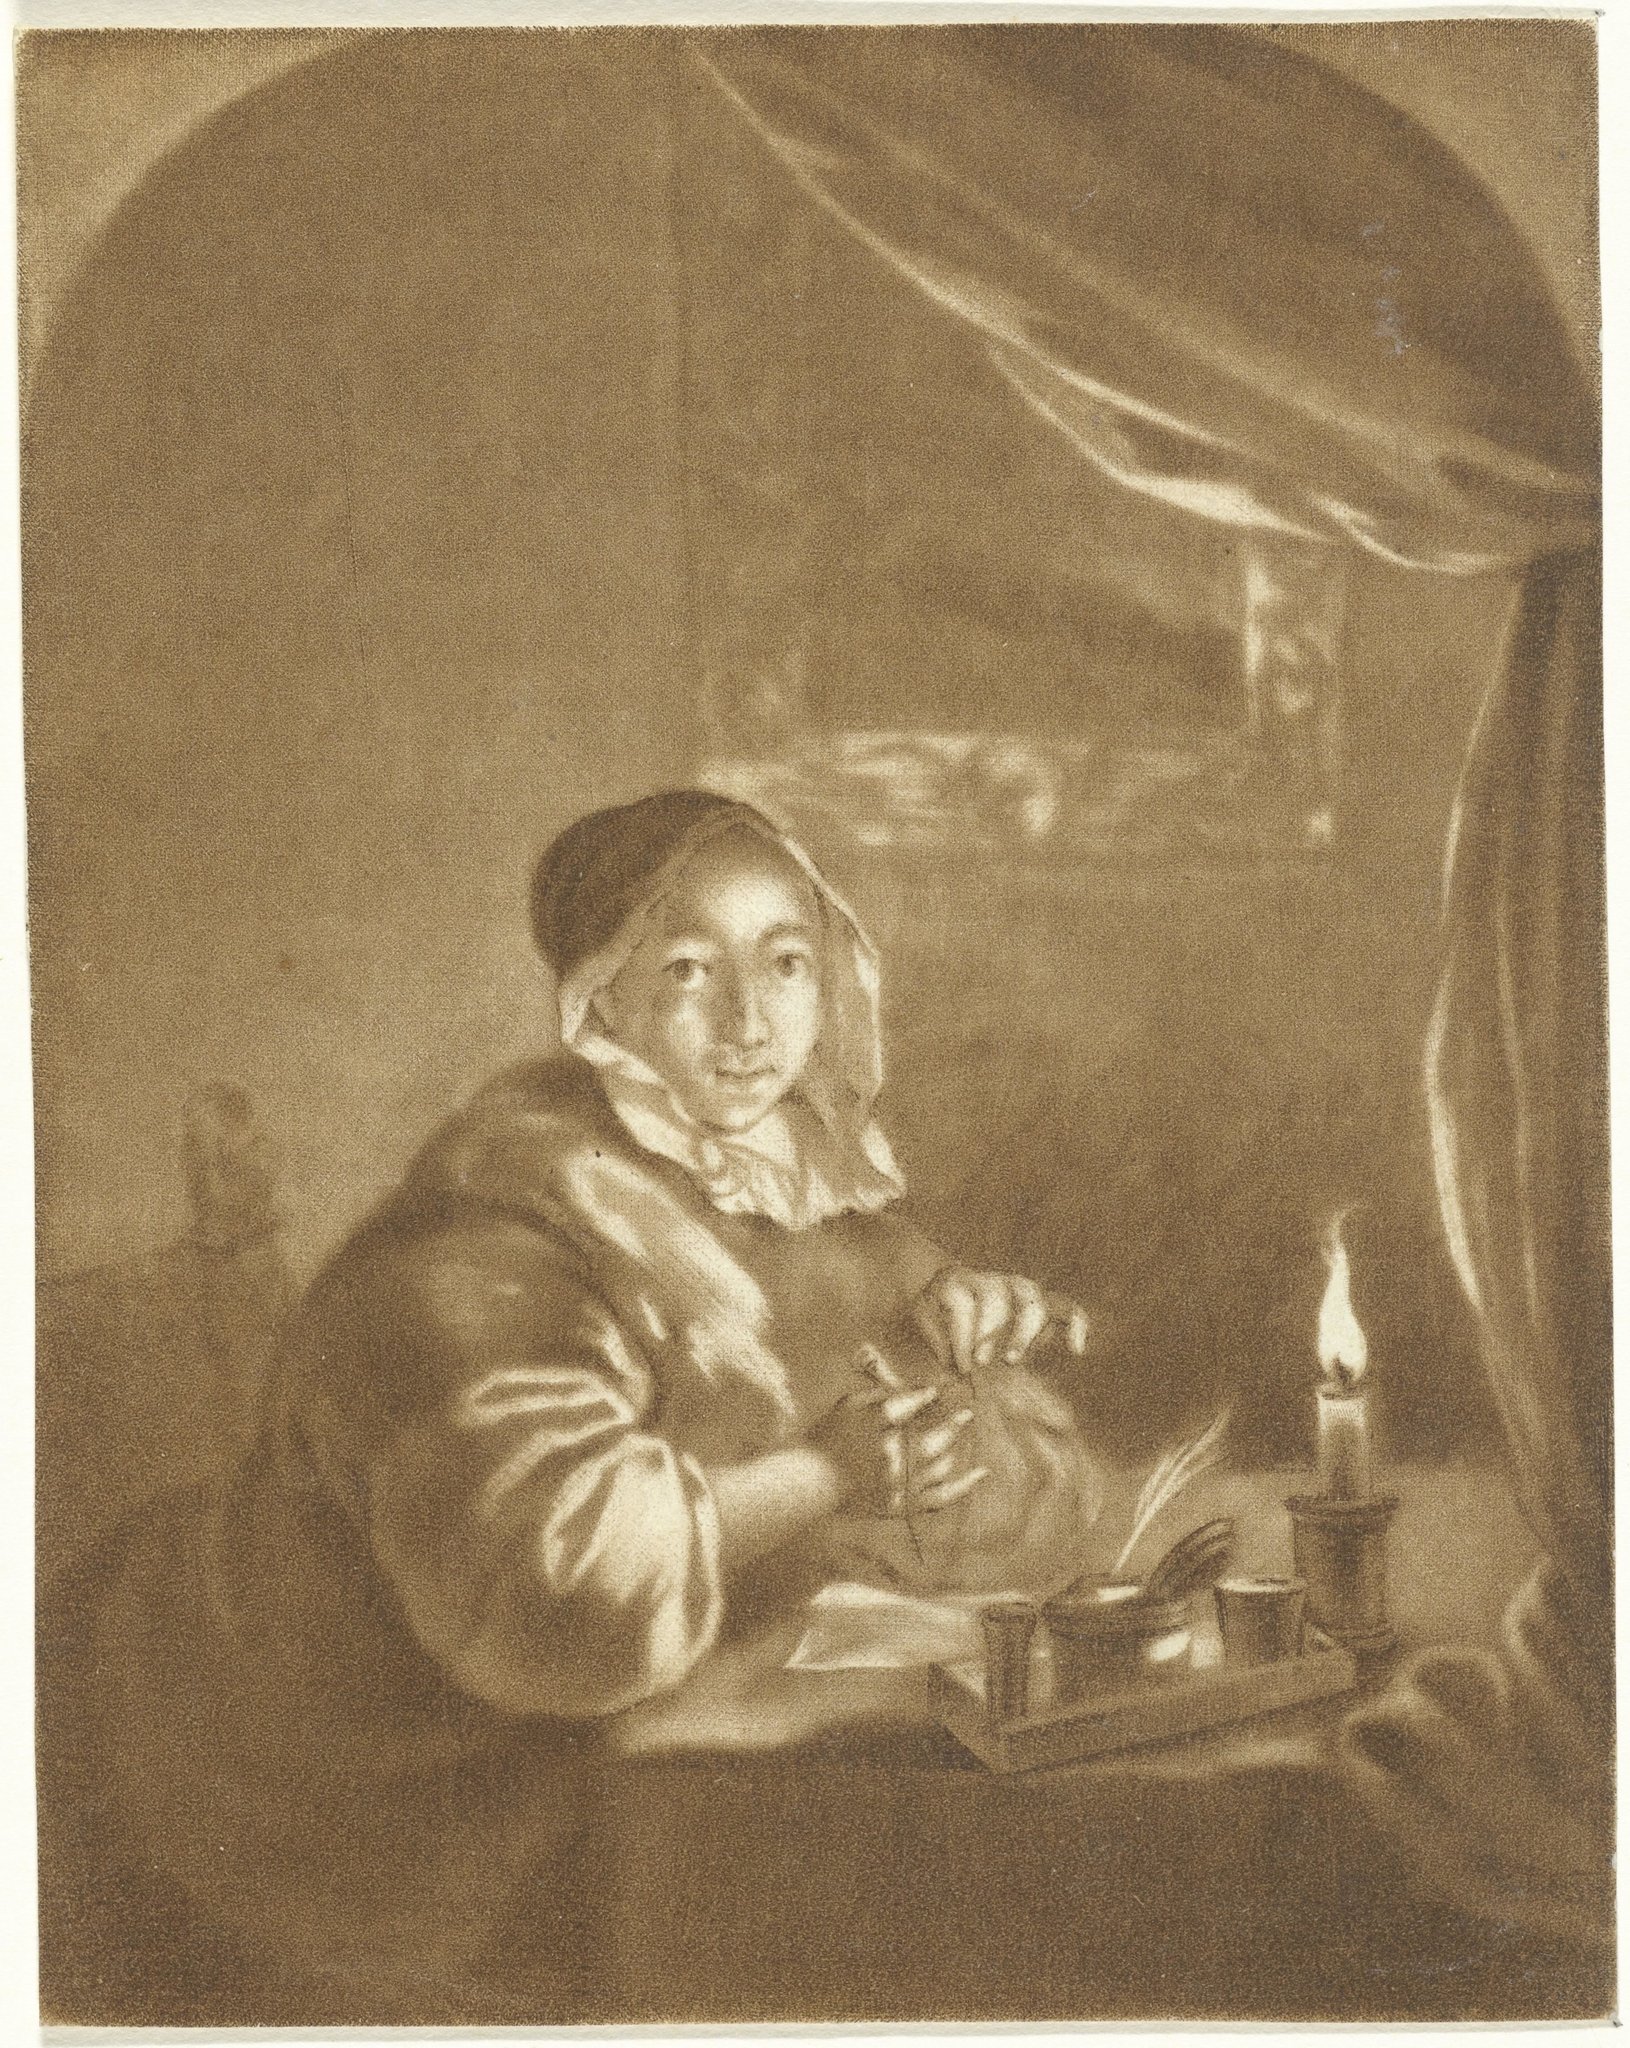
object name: print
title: Dame bij kaarslicht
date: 1736-1798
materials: paper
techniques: etching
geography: amsterdam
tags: candle, (other forms of) needlework, e.g.: crocheting, knitting, embroidering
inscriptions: collector's mark: Lugt 240, inscription: ‘Geoffreerd aan de WEd Heer van [...] ten verzoeke [...] vrind d'heer PlvAmstel G Nescher del Ploos v Amstel JC Fecit’, collector's mark: Lugt 2725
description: Een vrouw, zittend aan tafel met een breiwerk in de handen, bij kaarslicht.